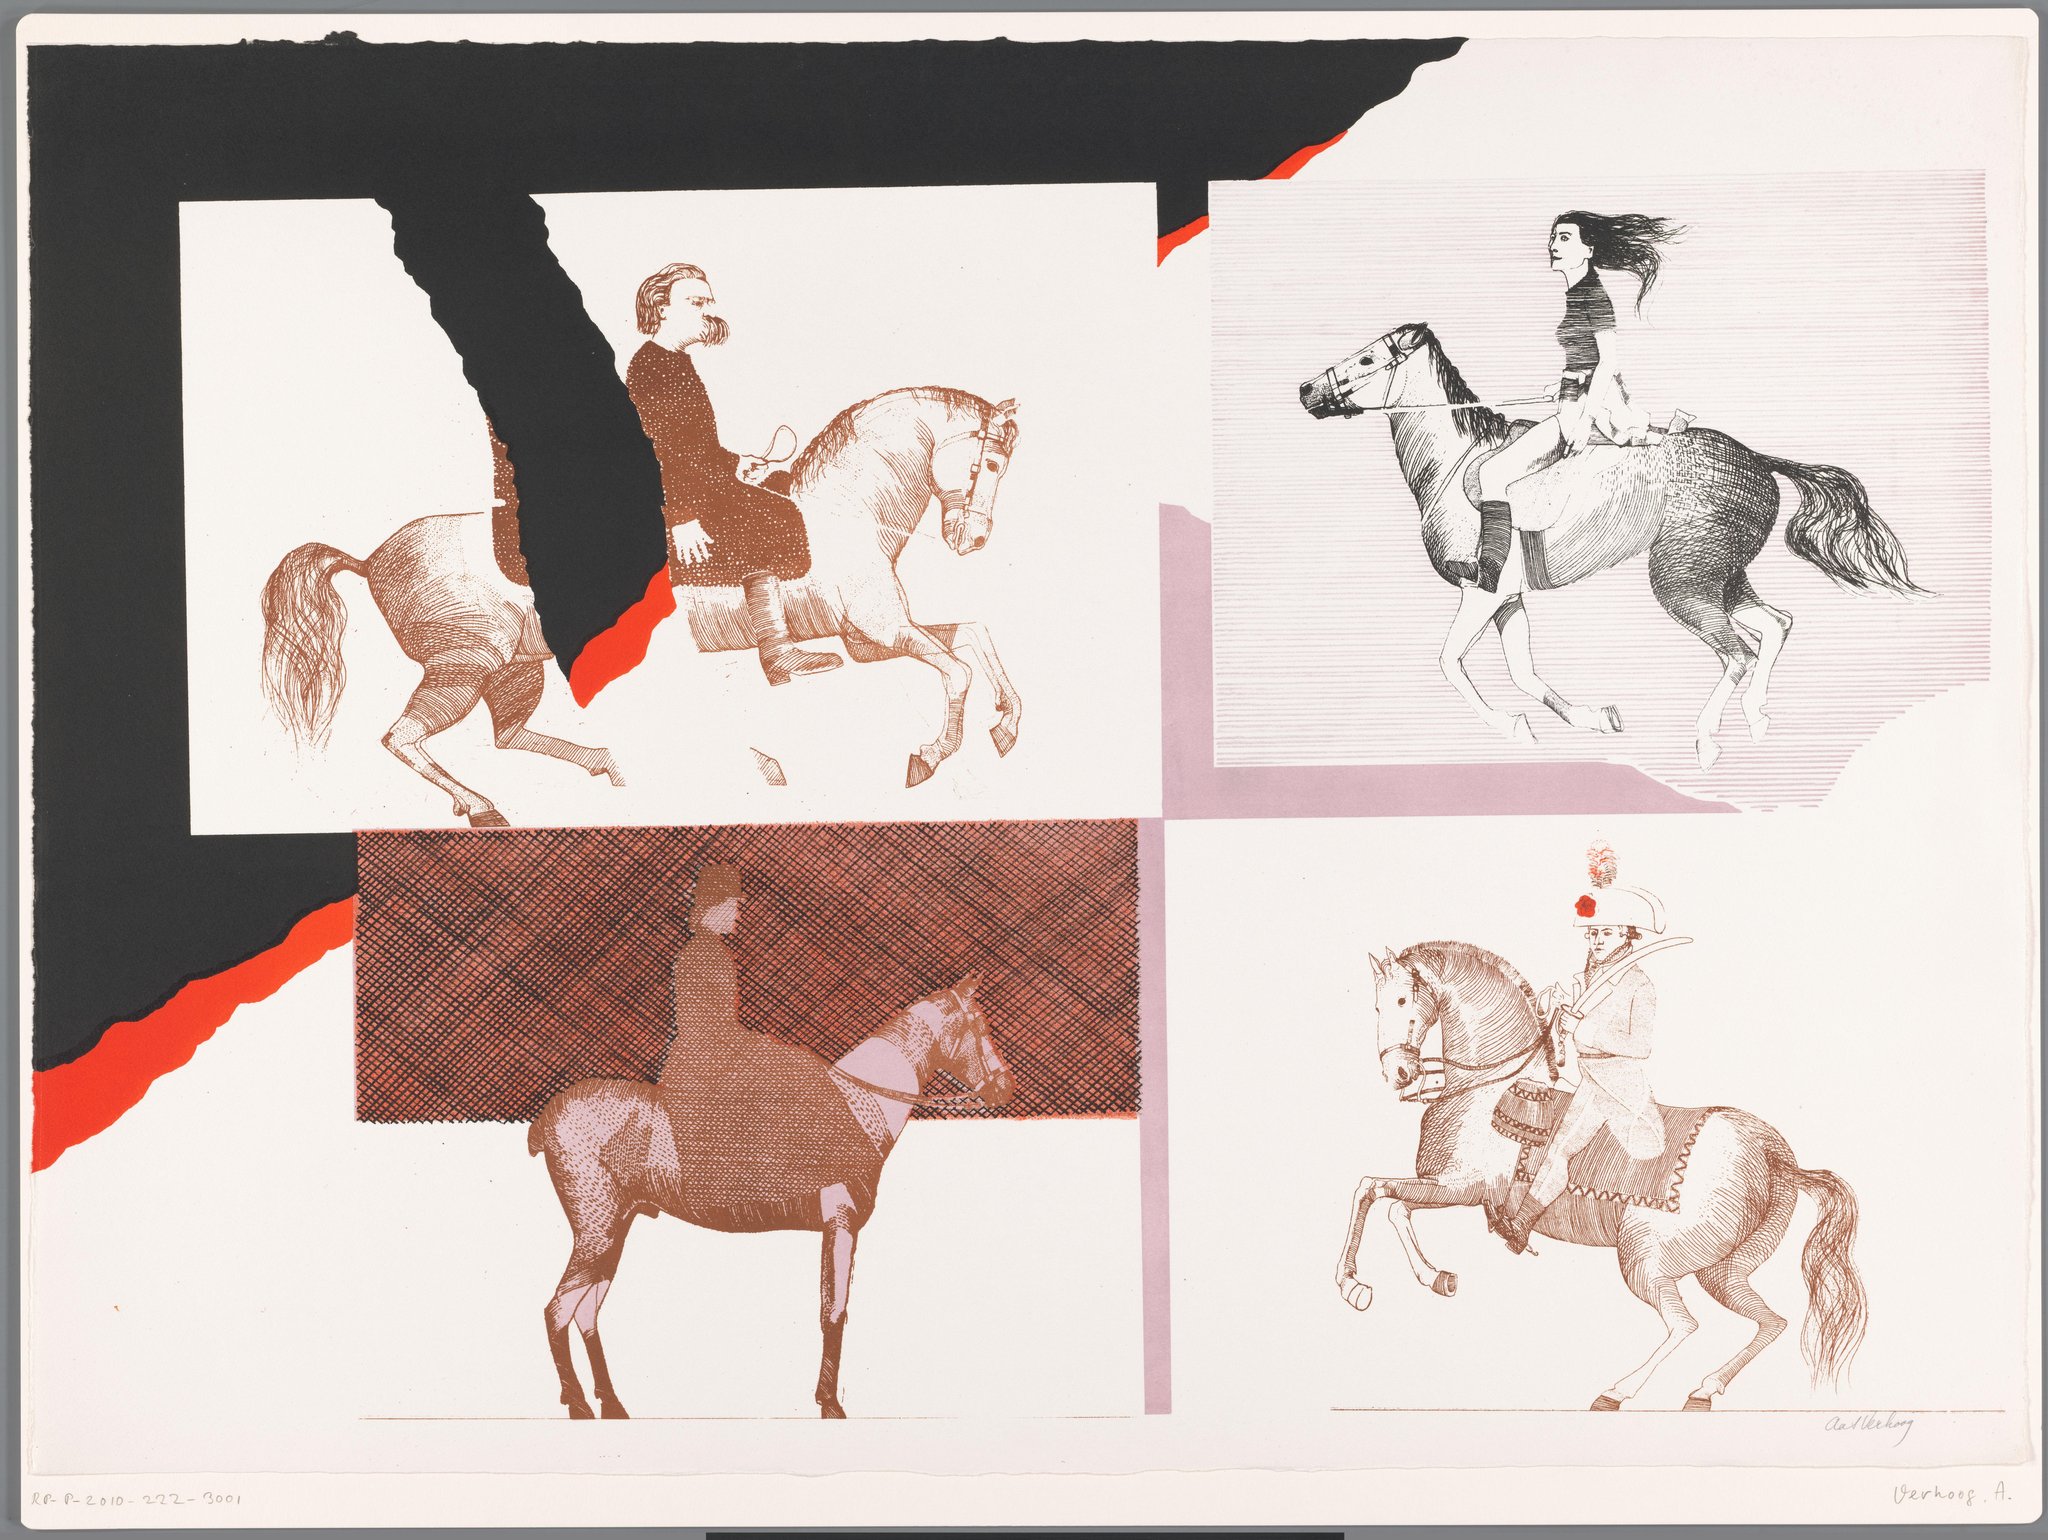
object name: print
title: Vier ruiters te paard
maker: aat verhoog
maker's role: print maker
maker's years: 1933-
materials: paper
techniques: lithograph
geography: amsterdam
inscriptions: signature: ‘Aat Verhoog’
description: Vier ruiters te paard, waaronder Napoleon en Nietzsche, tegen een achtergrond met zogenaamde papierscheuren in rood, zwart en roze.